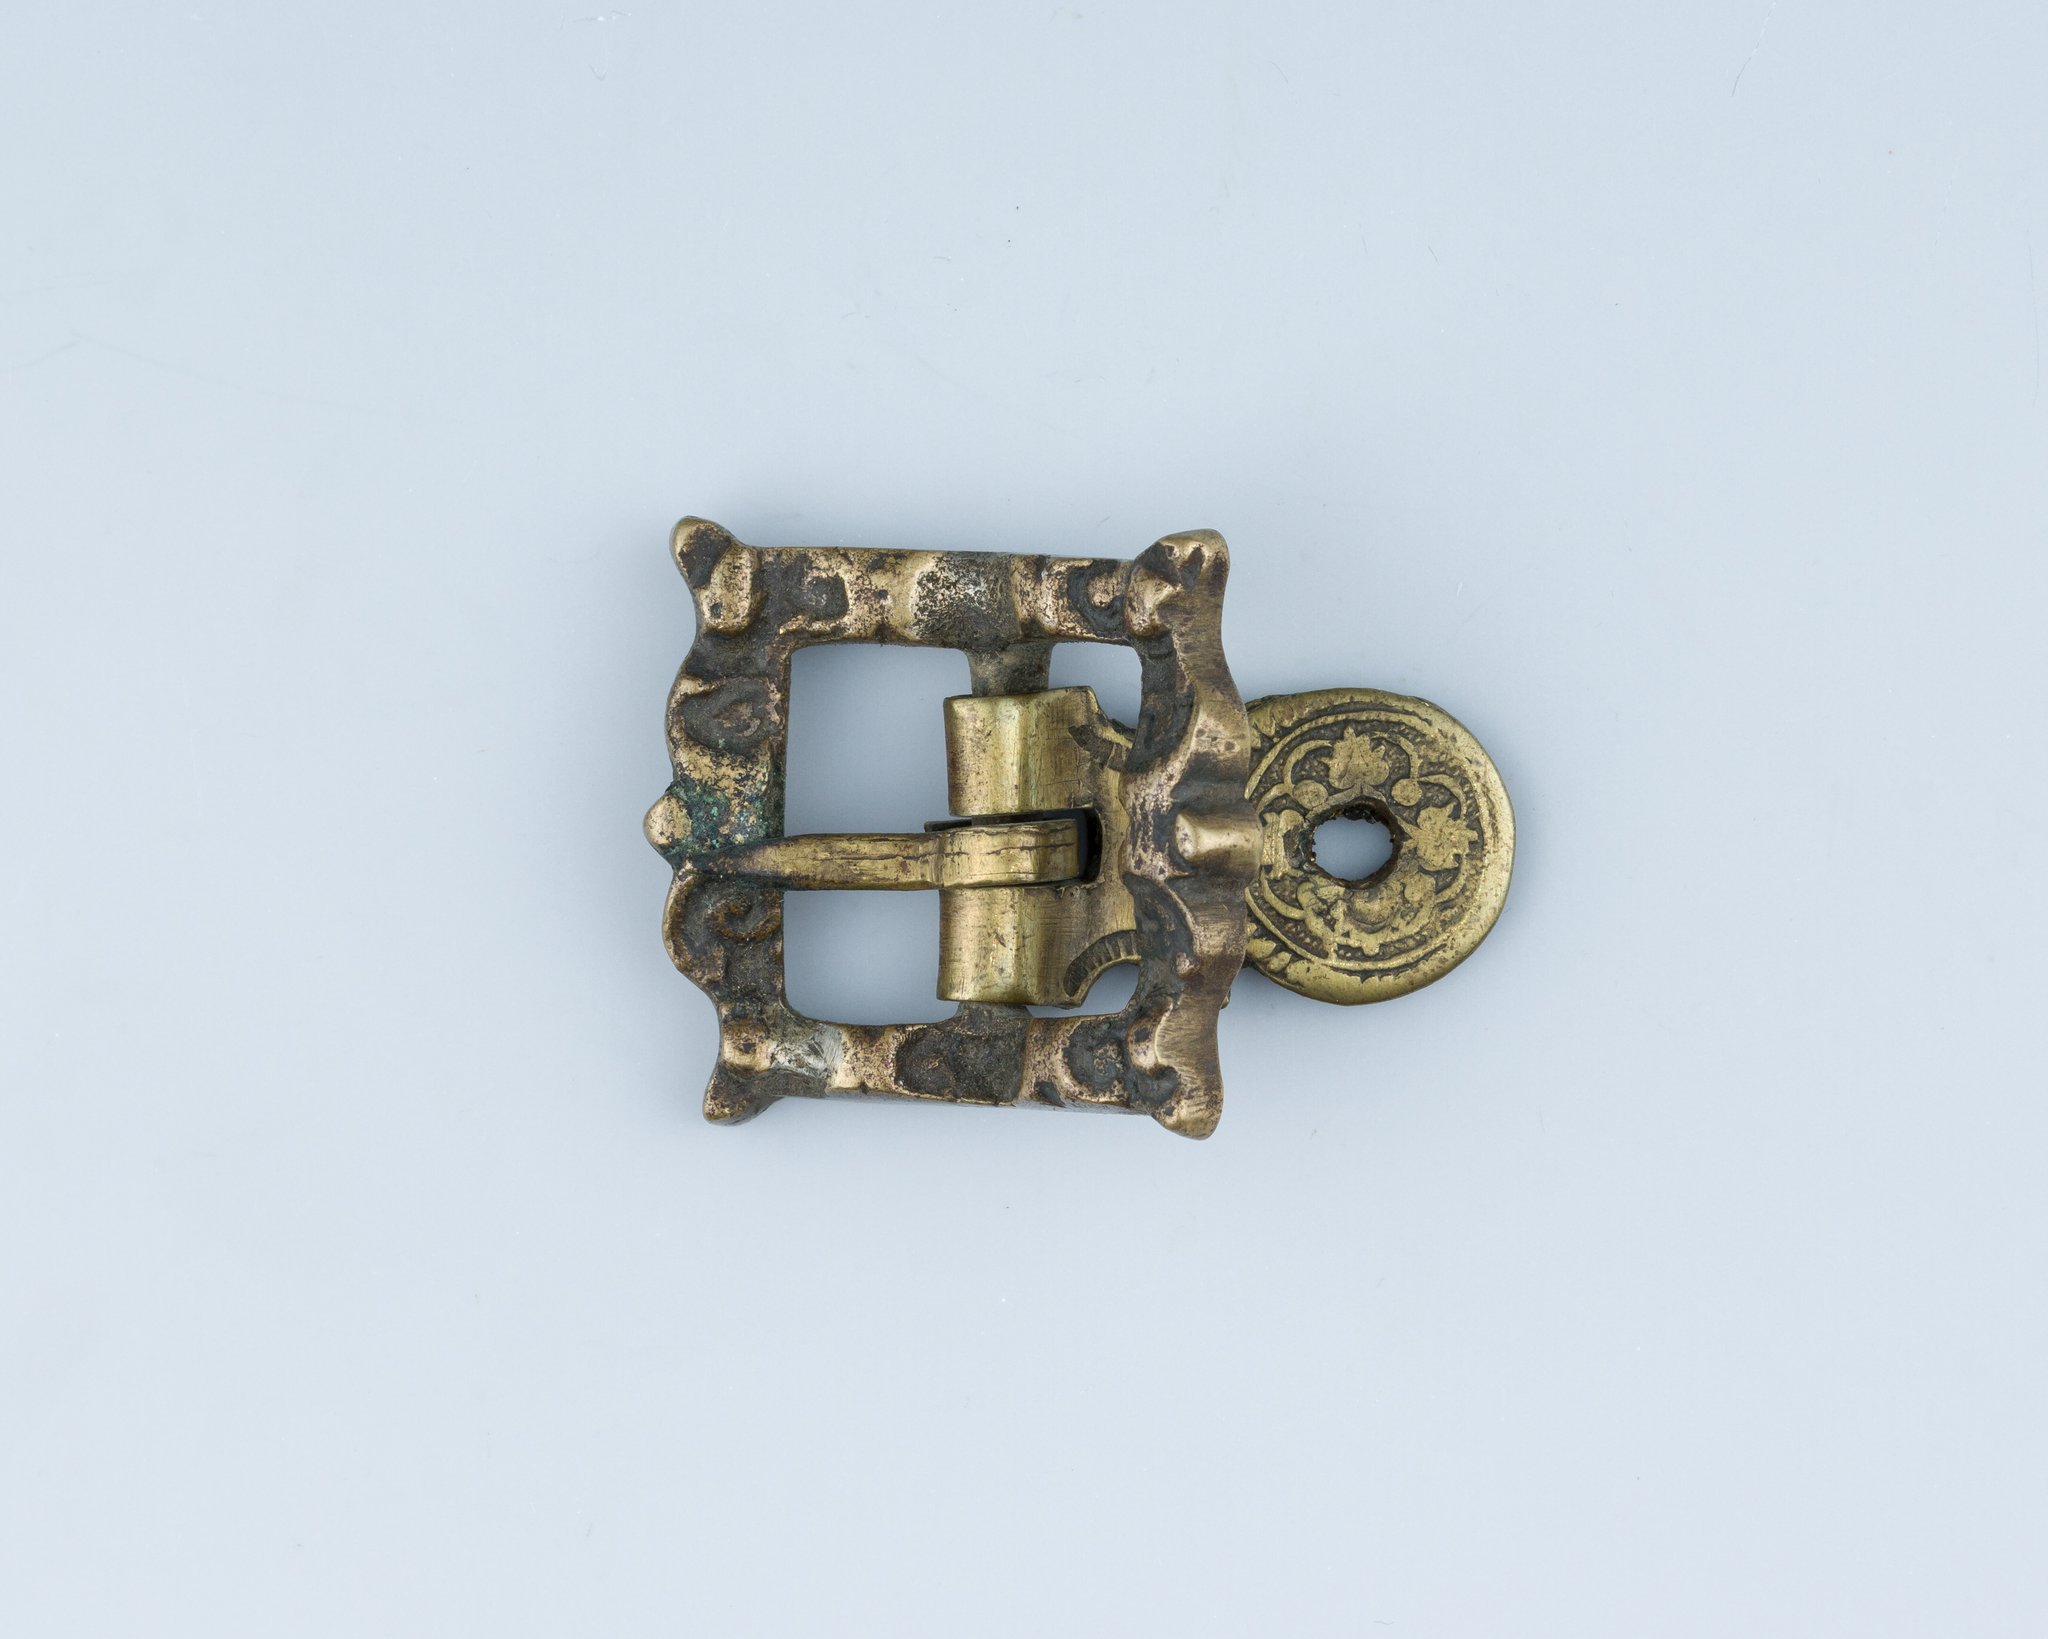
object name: buckle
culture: german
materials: brass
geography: germany